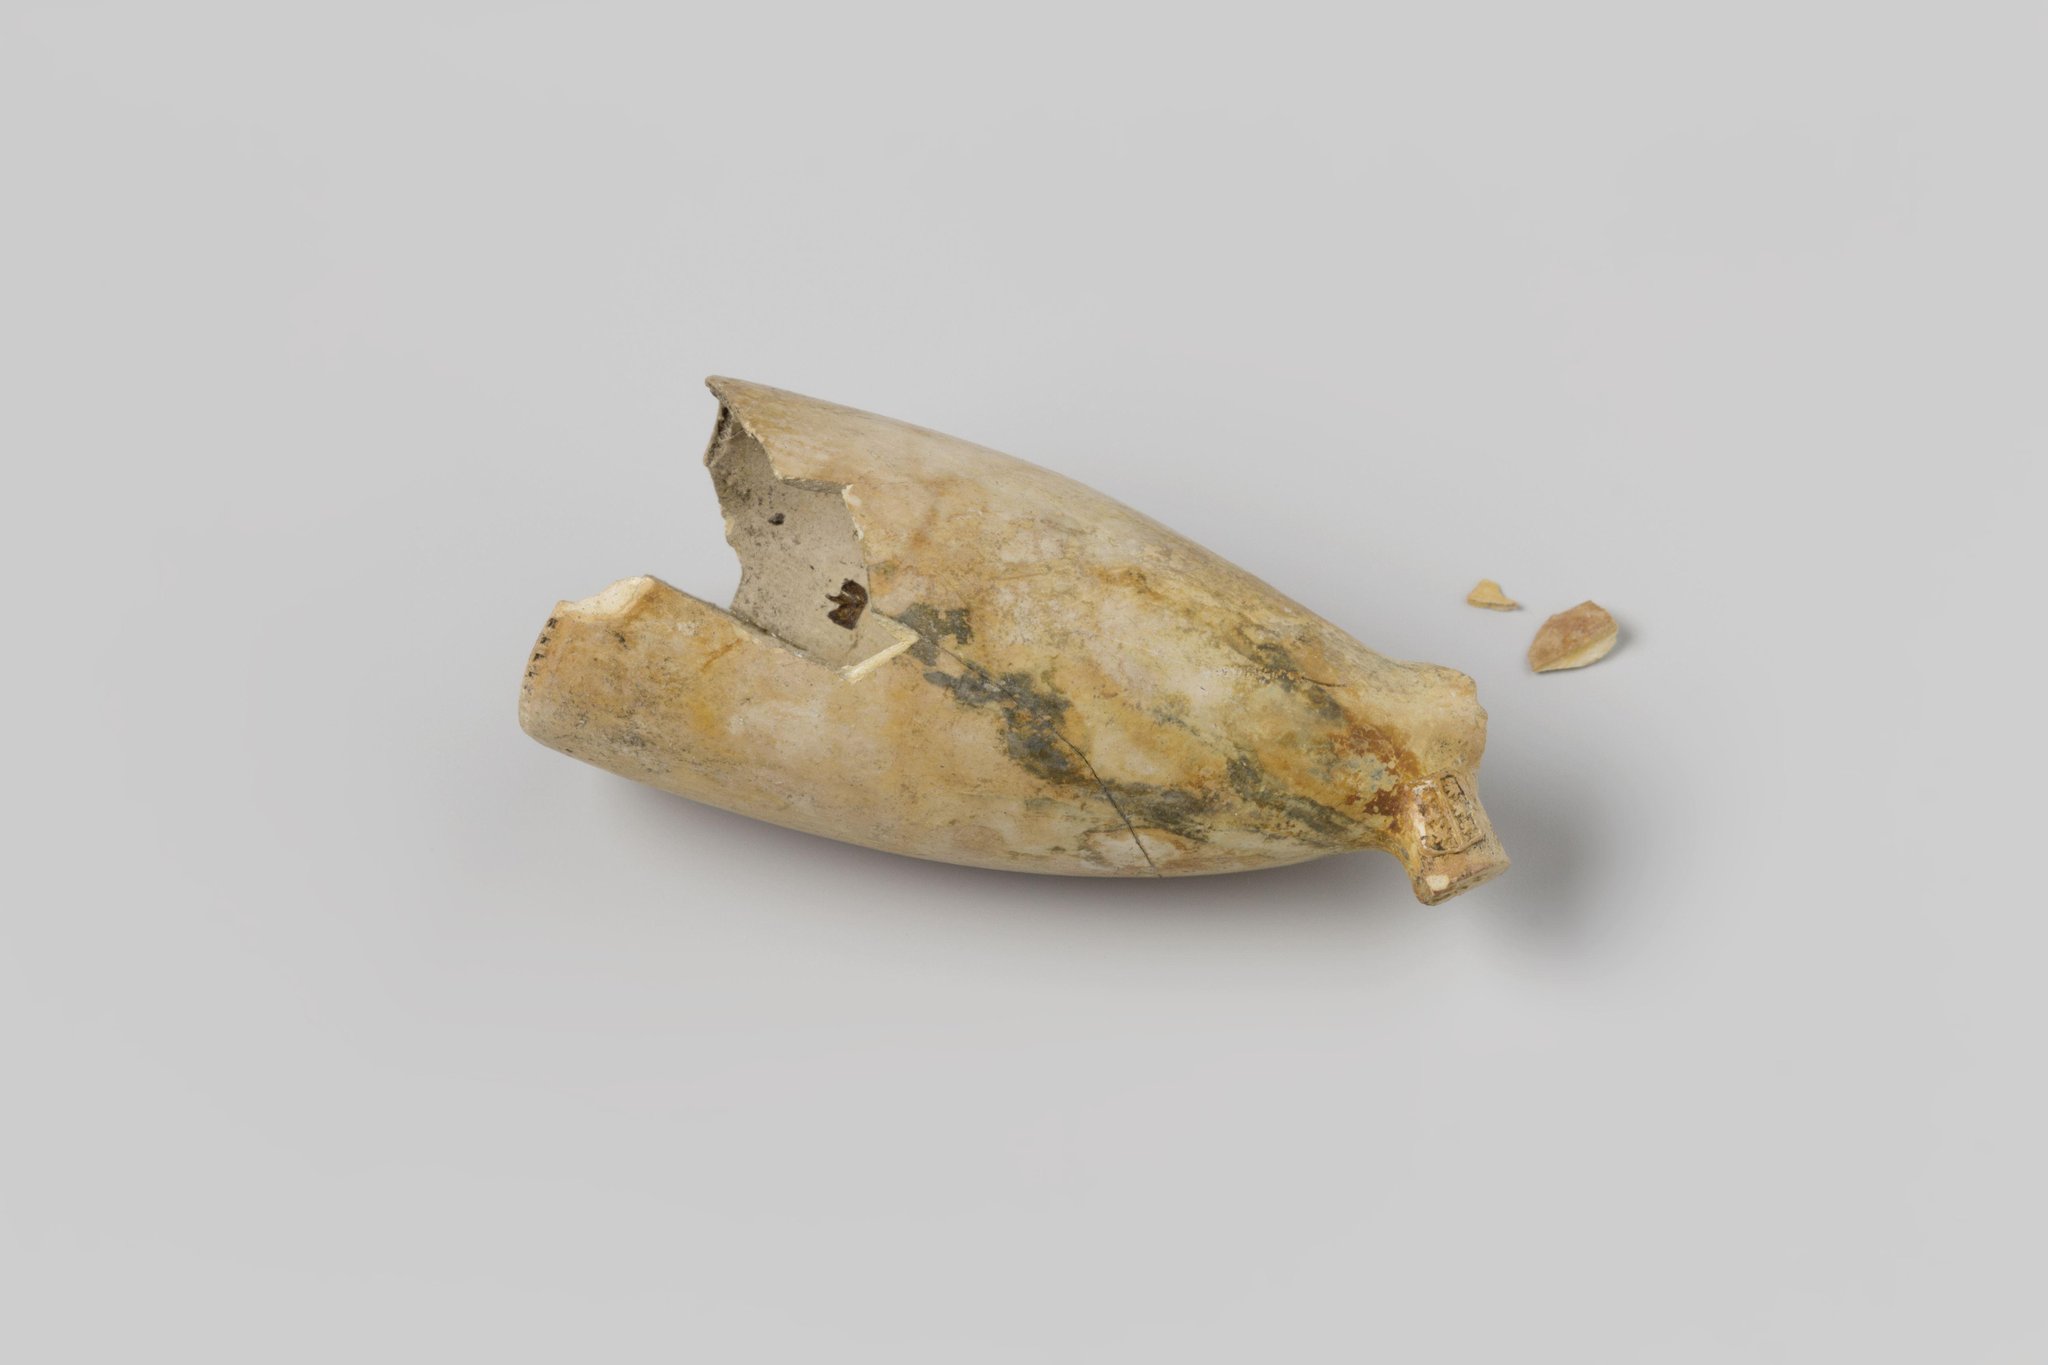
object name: pipe bowl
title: Pijpenkop uit het wrak van de Oost-Indiëvaarder Hollandia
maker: Anonymous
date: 1700-1743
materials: clay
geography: netherlands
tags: verenigde oostindische compagnie, hollandia (schip), annet, breda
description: Pipe, bowl, heelmark: three crosses (coat of arms of the city of Breda); fragm, 1hsm1.